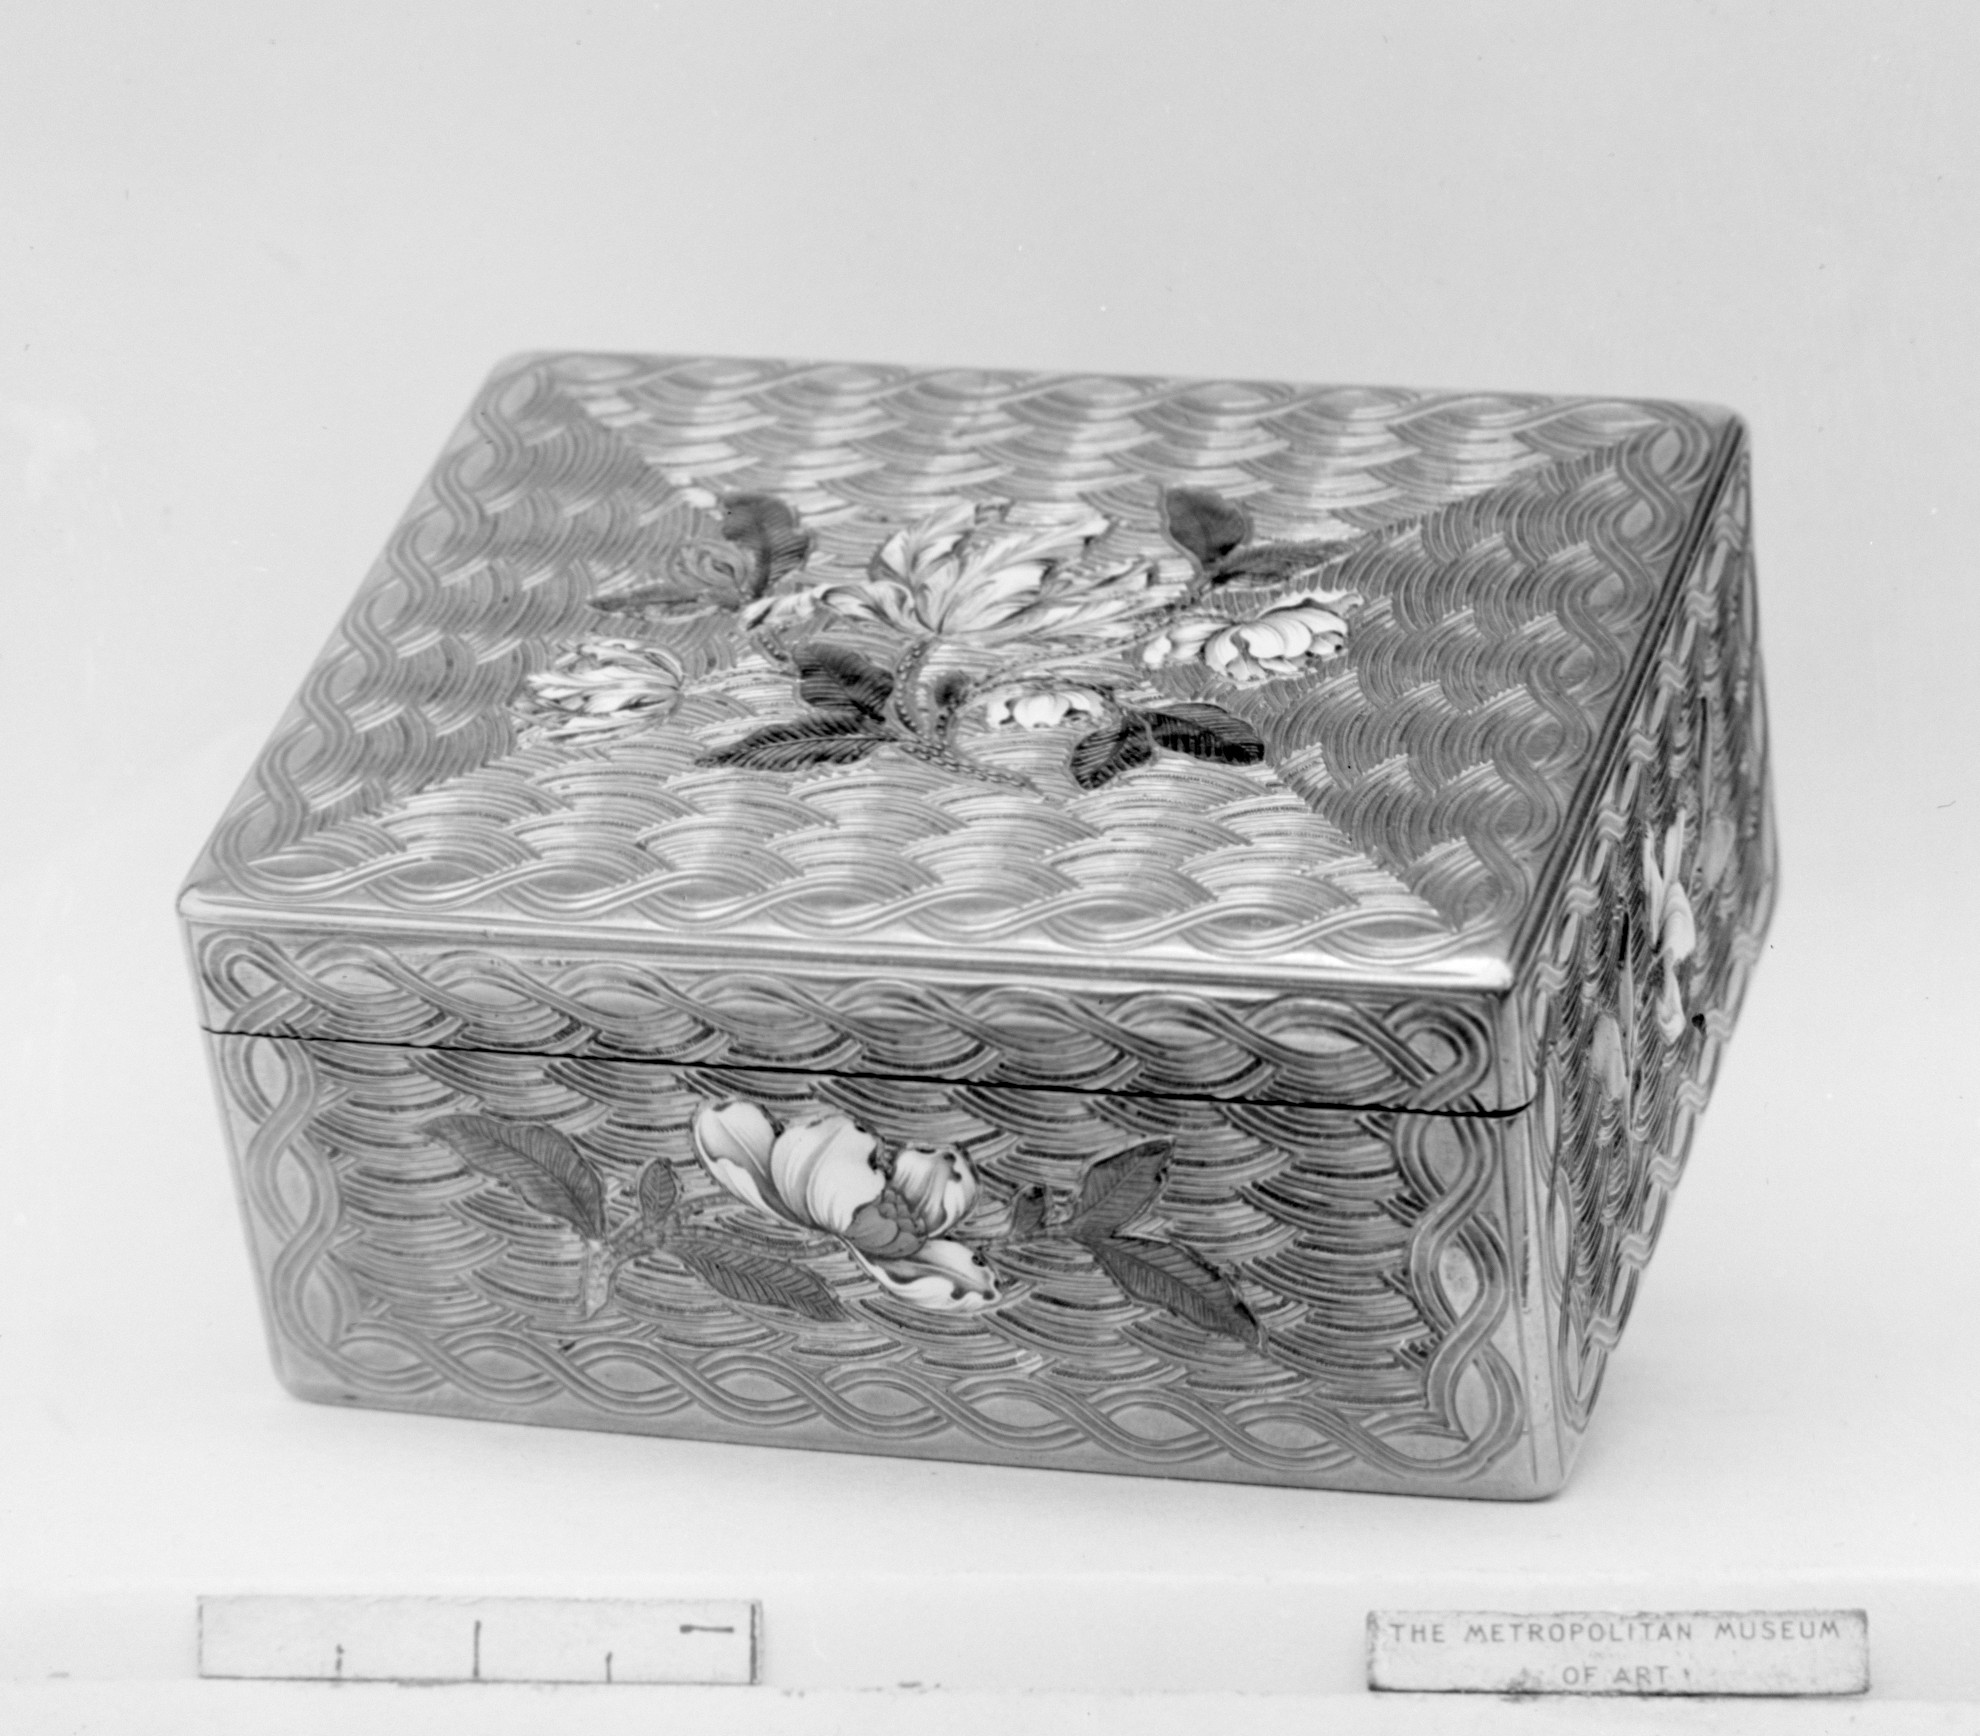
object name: snuffbox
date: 1749-1750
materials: enamel, gold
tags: flowers